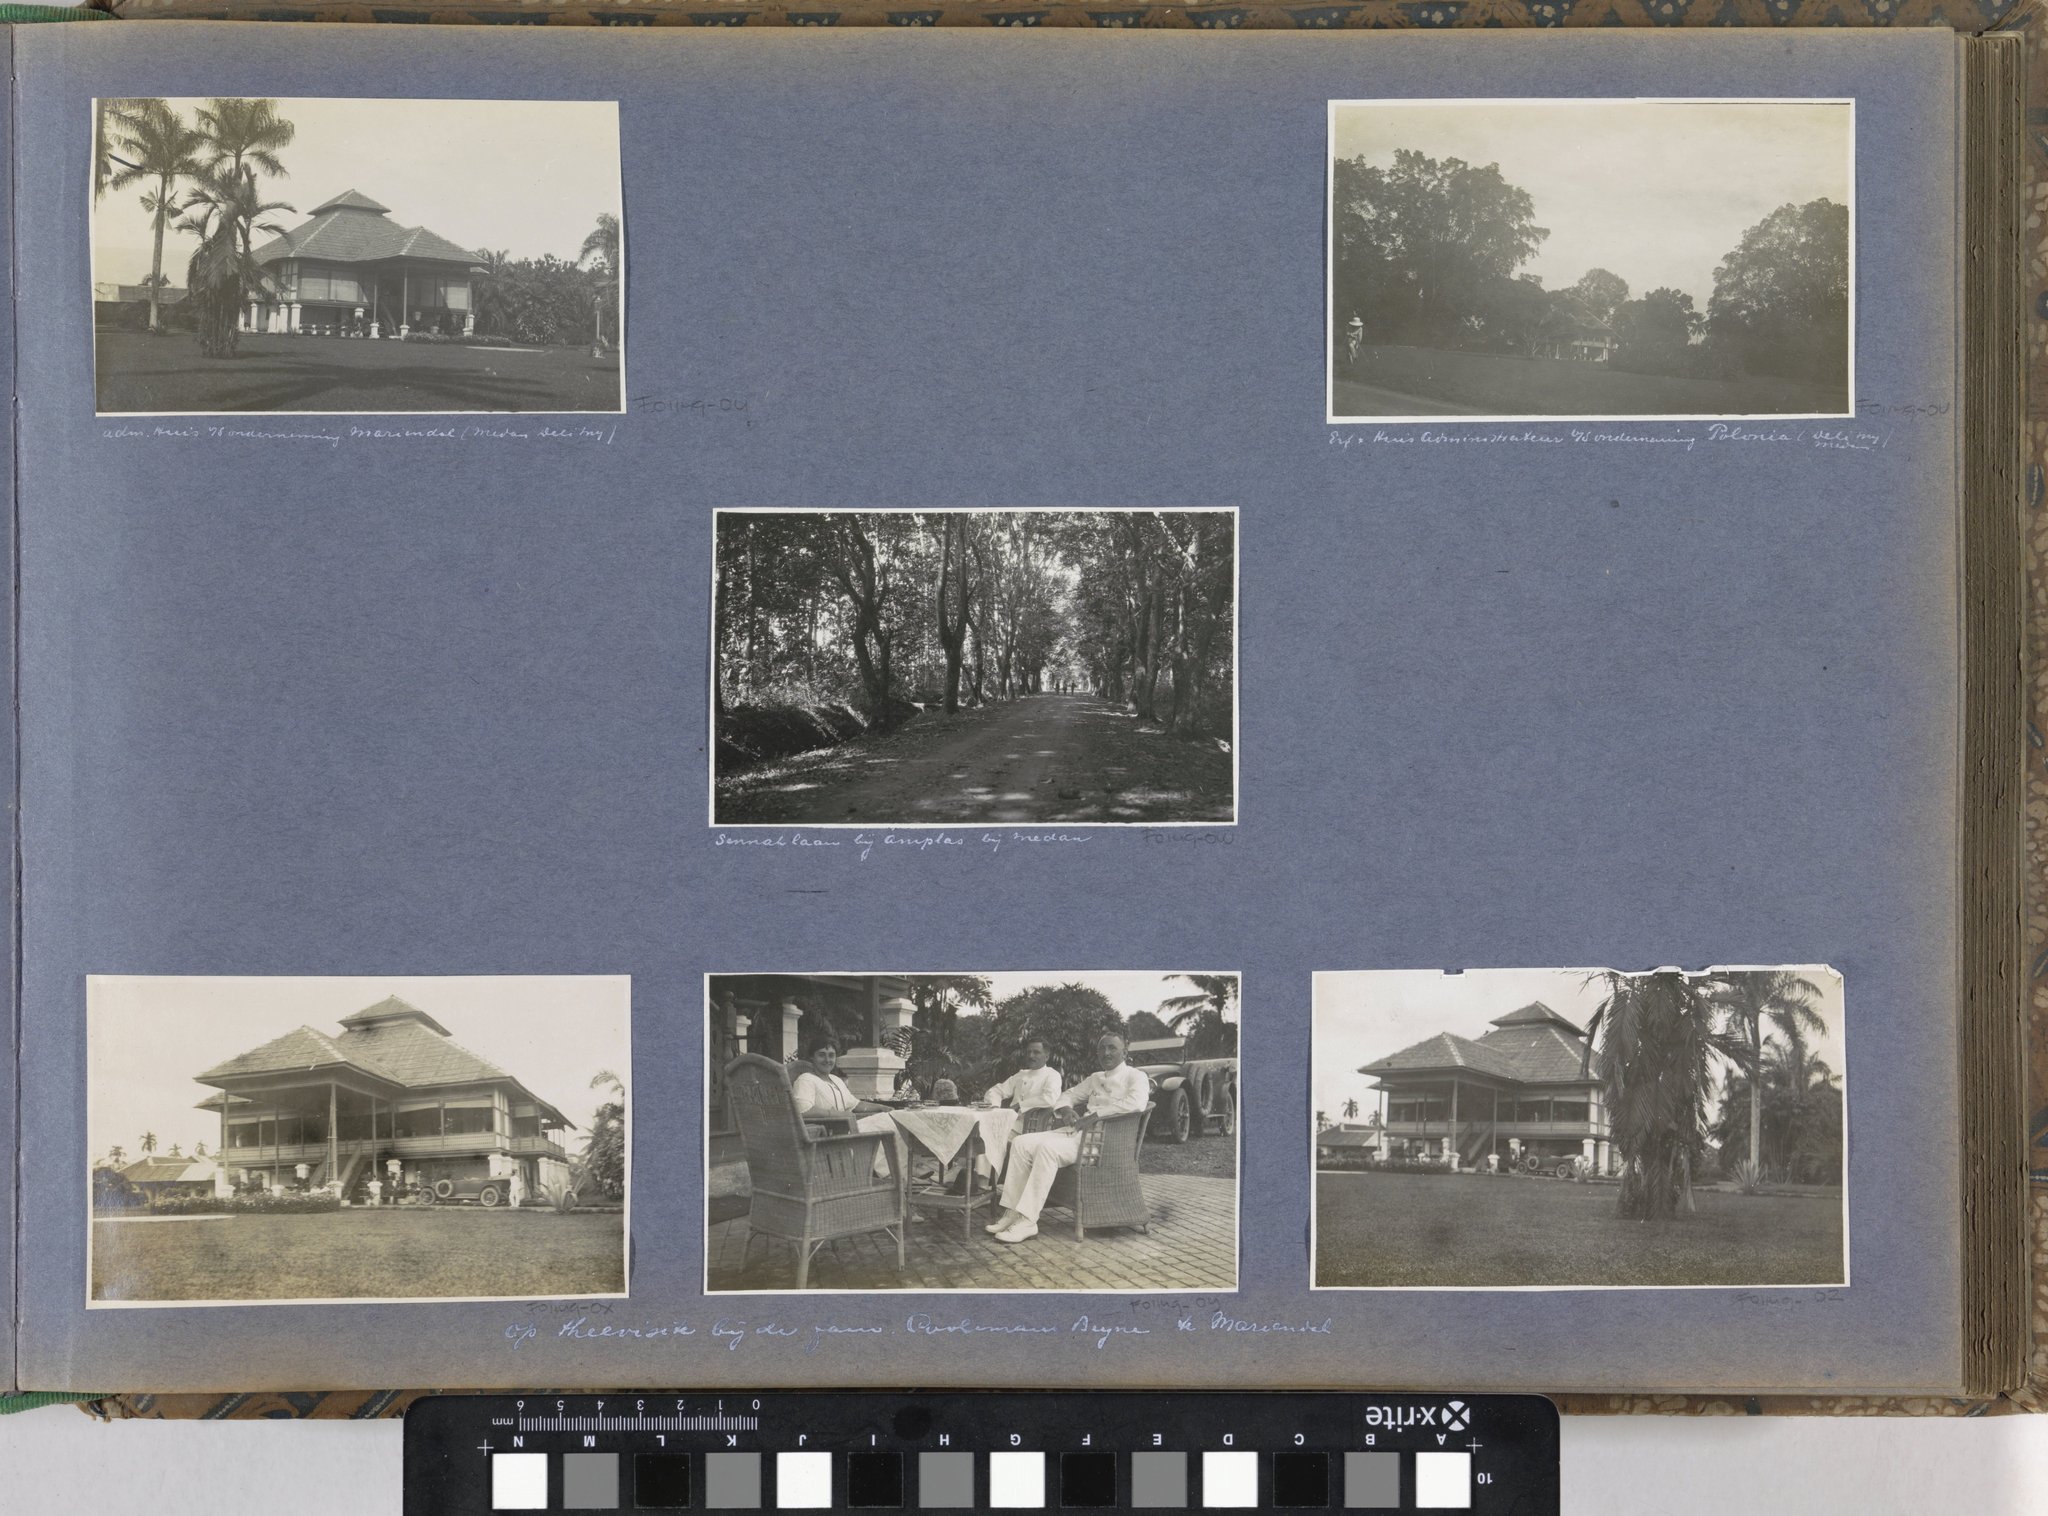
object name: album leaf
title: Sennahlaan bij Amplas op Sumatra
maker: Anonymous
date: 1900-1920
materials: paper, photographic support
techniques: gelatin silver print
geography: sumatra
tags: forest path or lane, sumatra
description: Onderdeel van reisalbum met foto's van bedrijvigheid en bezienswaardigheden op Sumatra en Java en van de reis naar en van Nederlands-Indië.